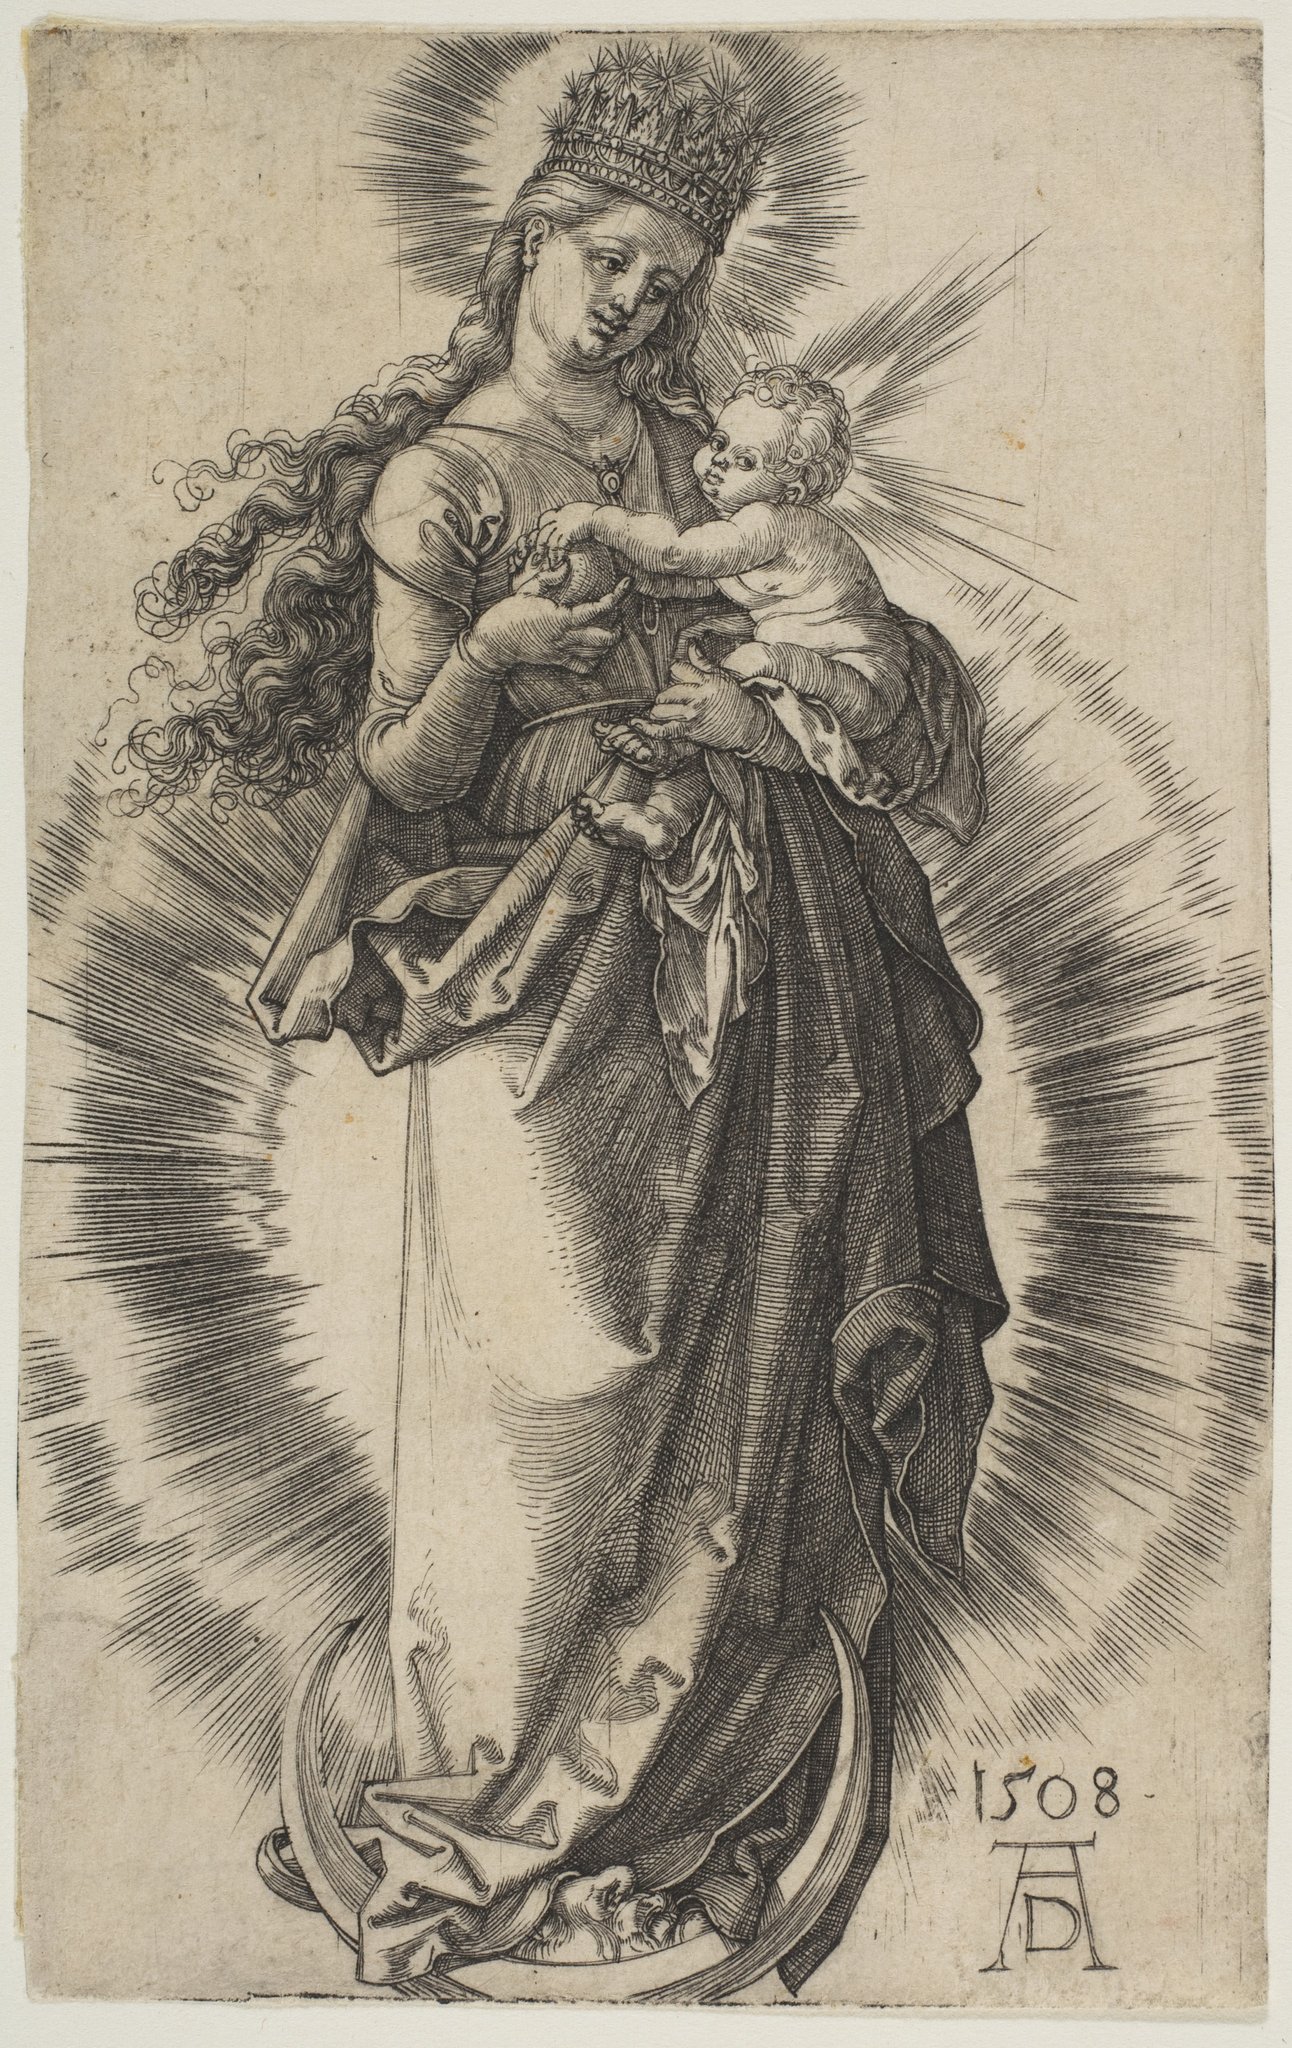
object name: print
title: Virgin on the Crescent with a Starry Crown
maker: albrecht dürer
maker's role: artist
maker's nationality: german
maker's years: 1471-1528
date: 1508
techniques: engraving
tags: madonna and child